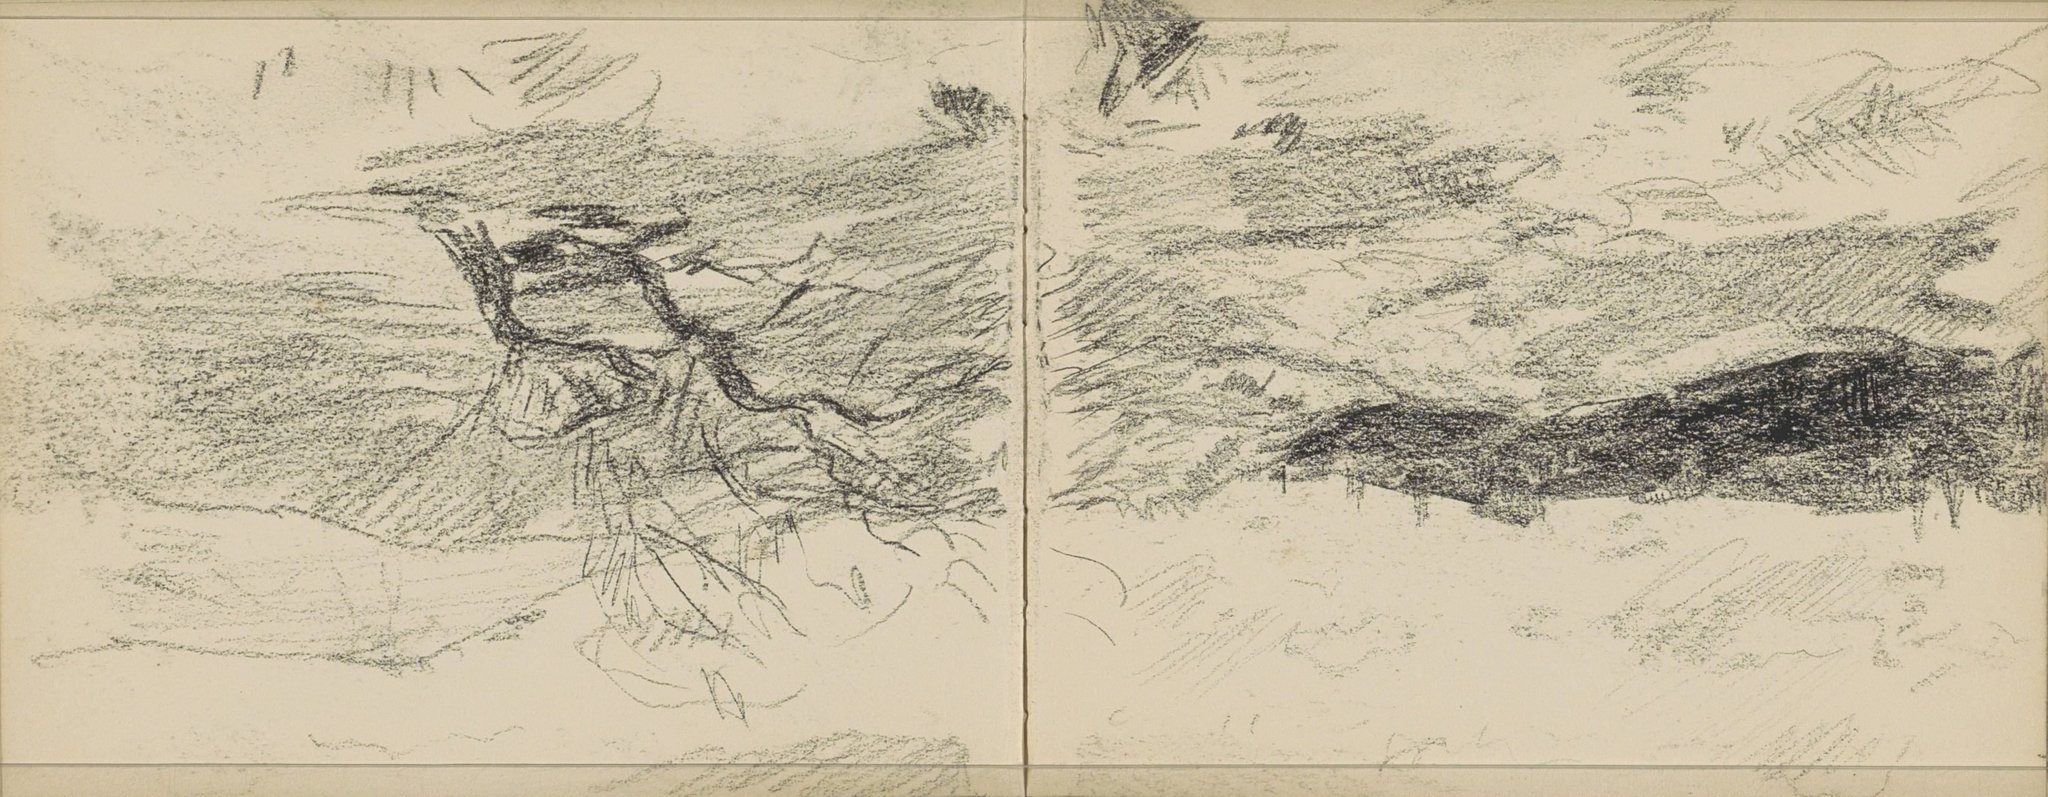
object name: sketchbook leaf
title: Landschap met twee bomen, mogelijk een duinlandschap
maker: johan antonie de jonge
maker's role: draughtsman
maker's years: 1864-1927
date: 1881-1927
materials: chalk, paper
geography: south holland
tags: dune coast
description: Landschap met twee bomen, mogelijk een duinlandschap. Blad 24 verso en blad 25 recto uit een schetsboek met 34 bladen.